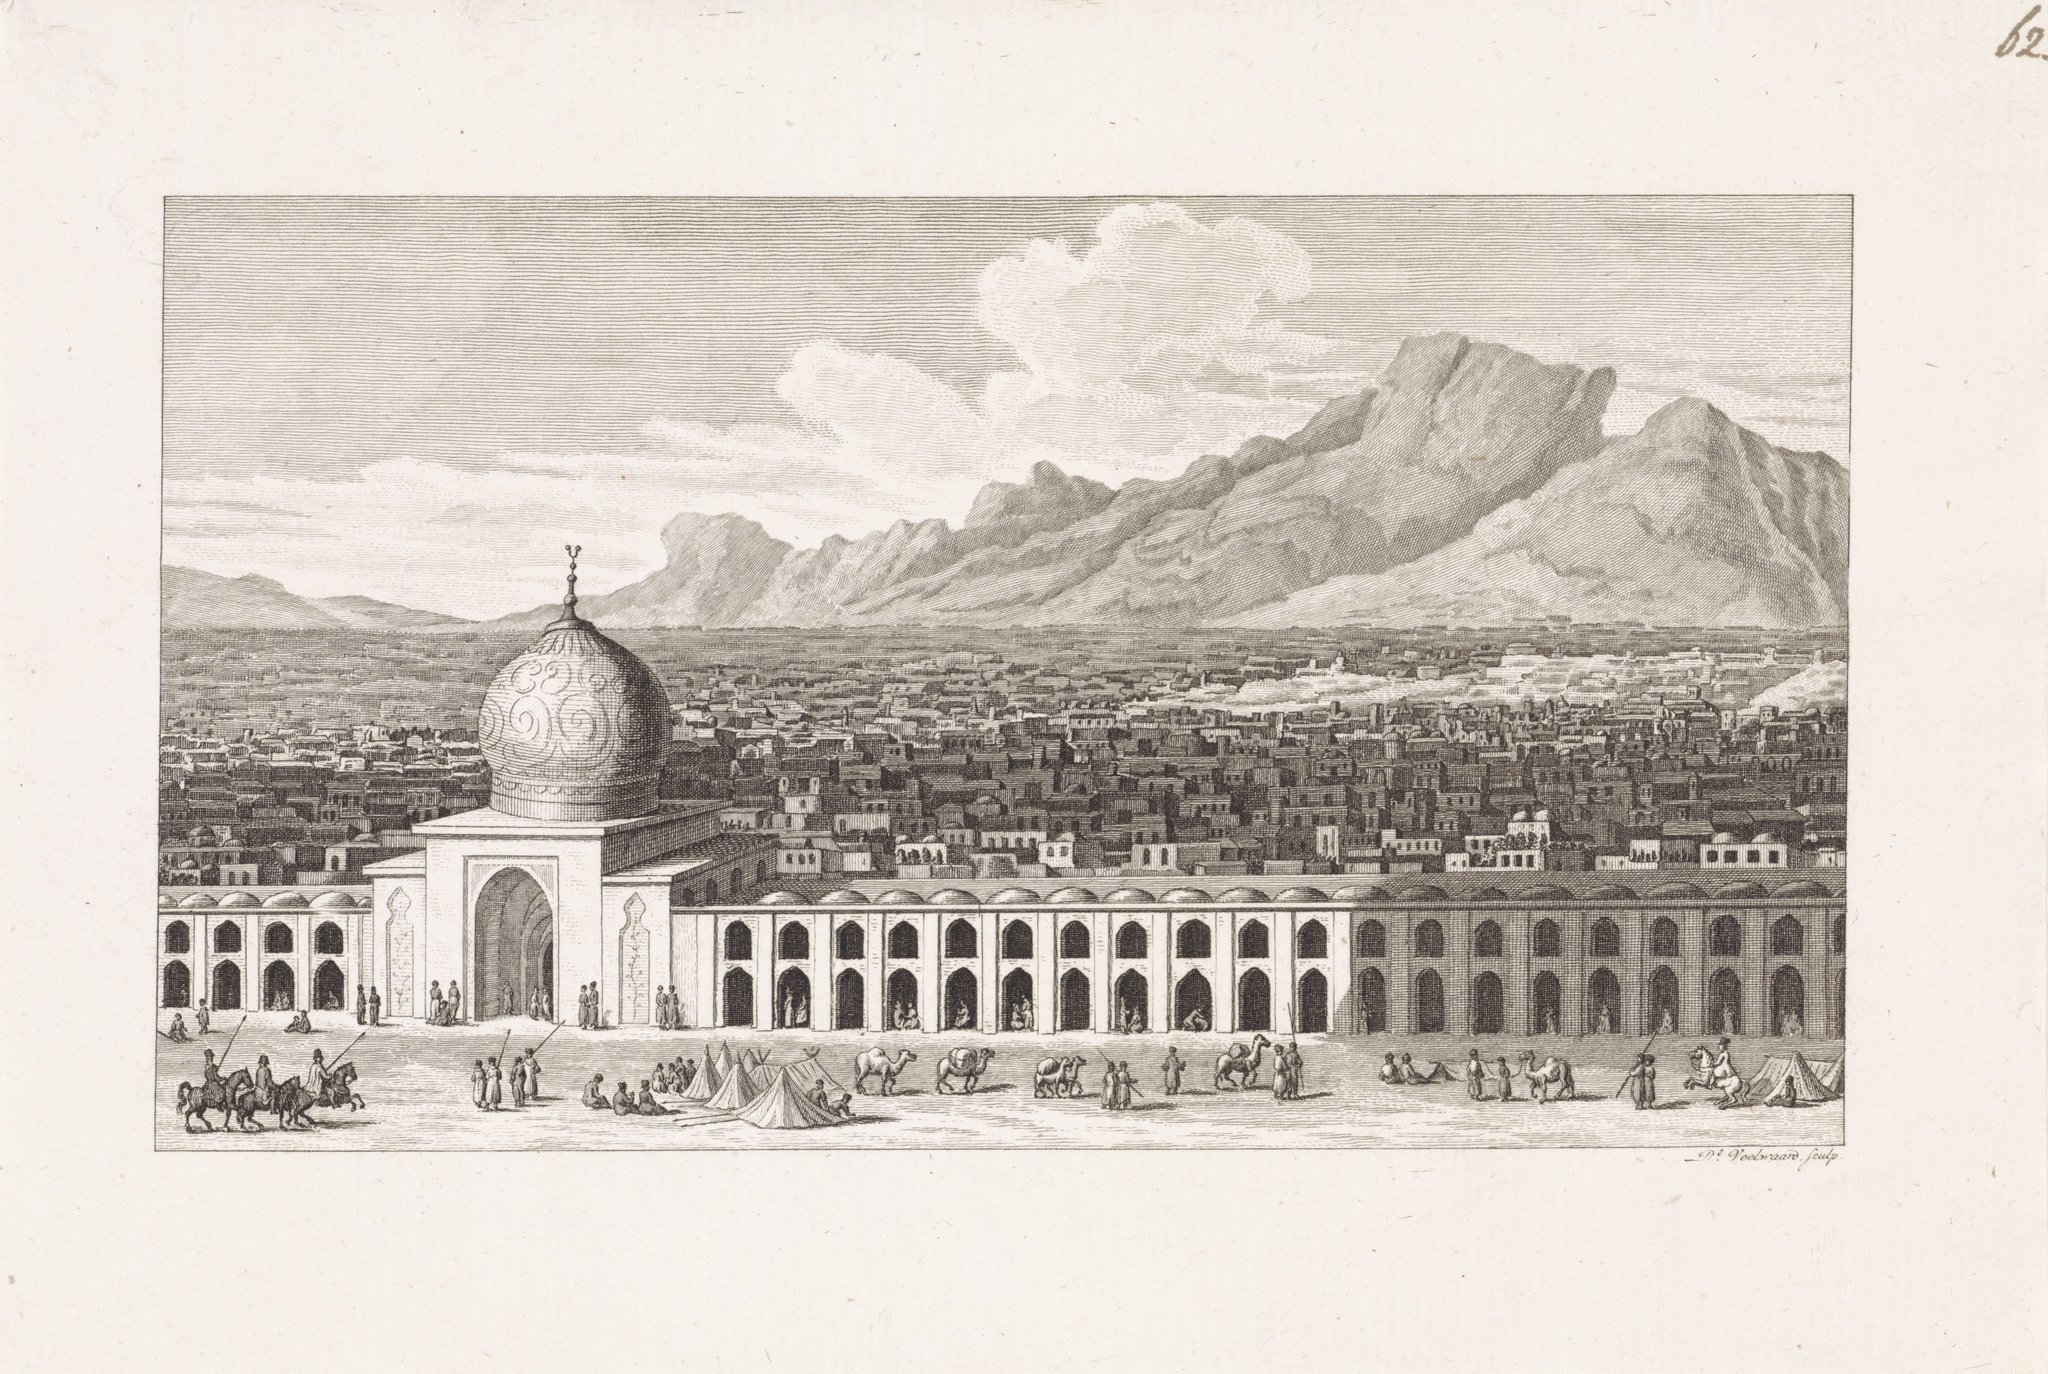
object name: print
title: Gezicht op een Arabische stad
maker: daniël veelwaard (i)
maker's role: print maker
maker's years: 1766-1851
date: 1776-1851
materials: paper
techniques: etching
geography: amsterdam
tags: city-view in general; 'veduta', city-gate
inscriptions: collector's mark: Lugt 2228, number: ‘62’